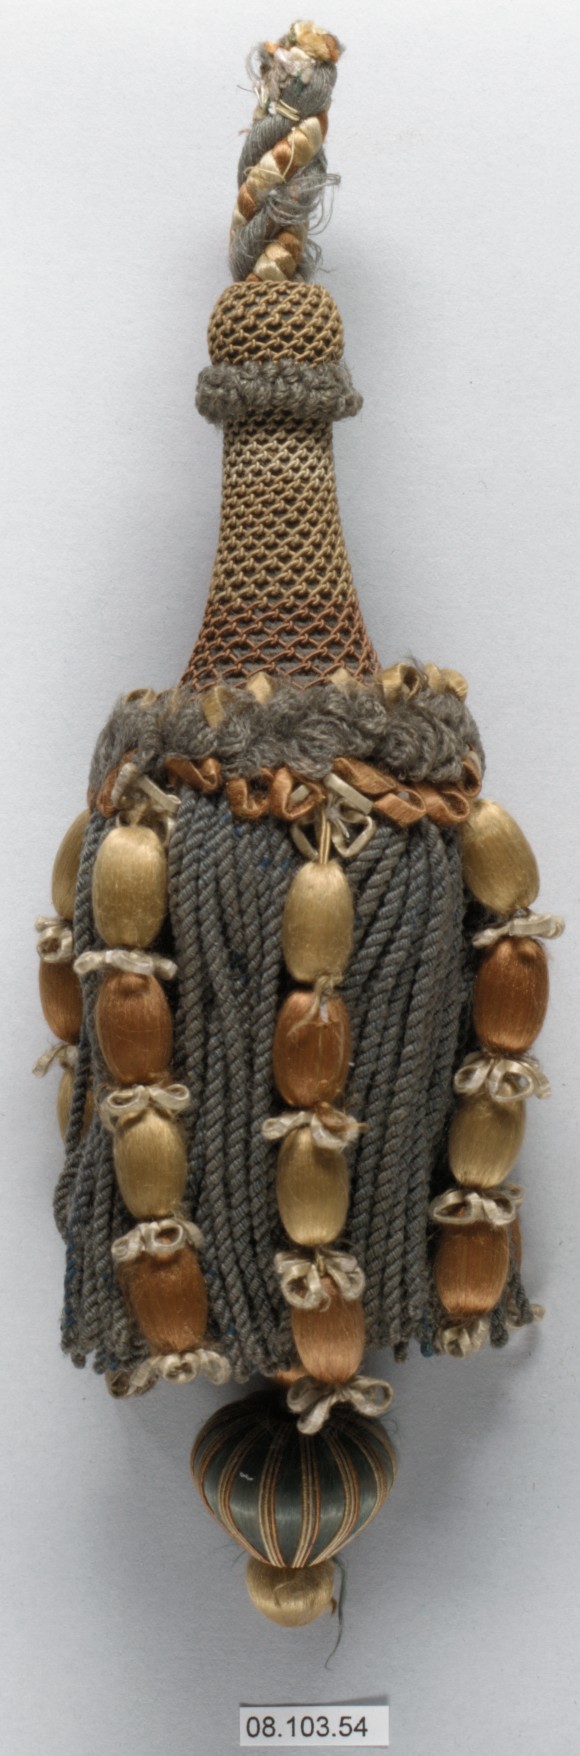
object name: tassel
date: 1801-1900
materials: cotton, silk